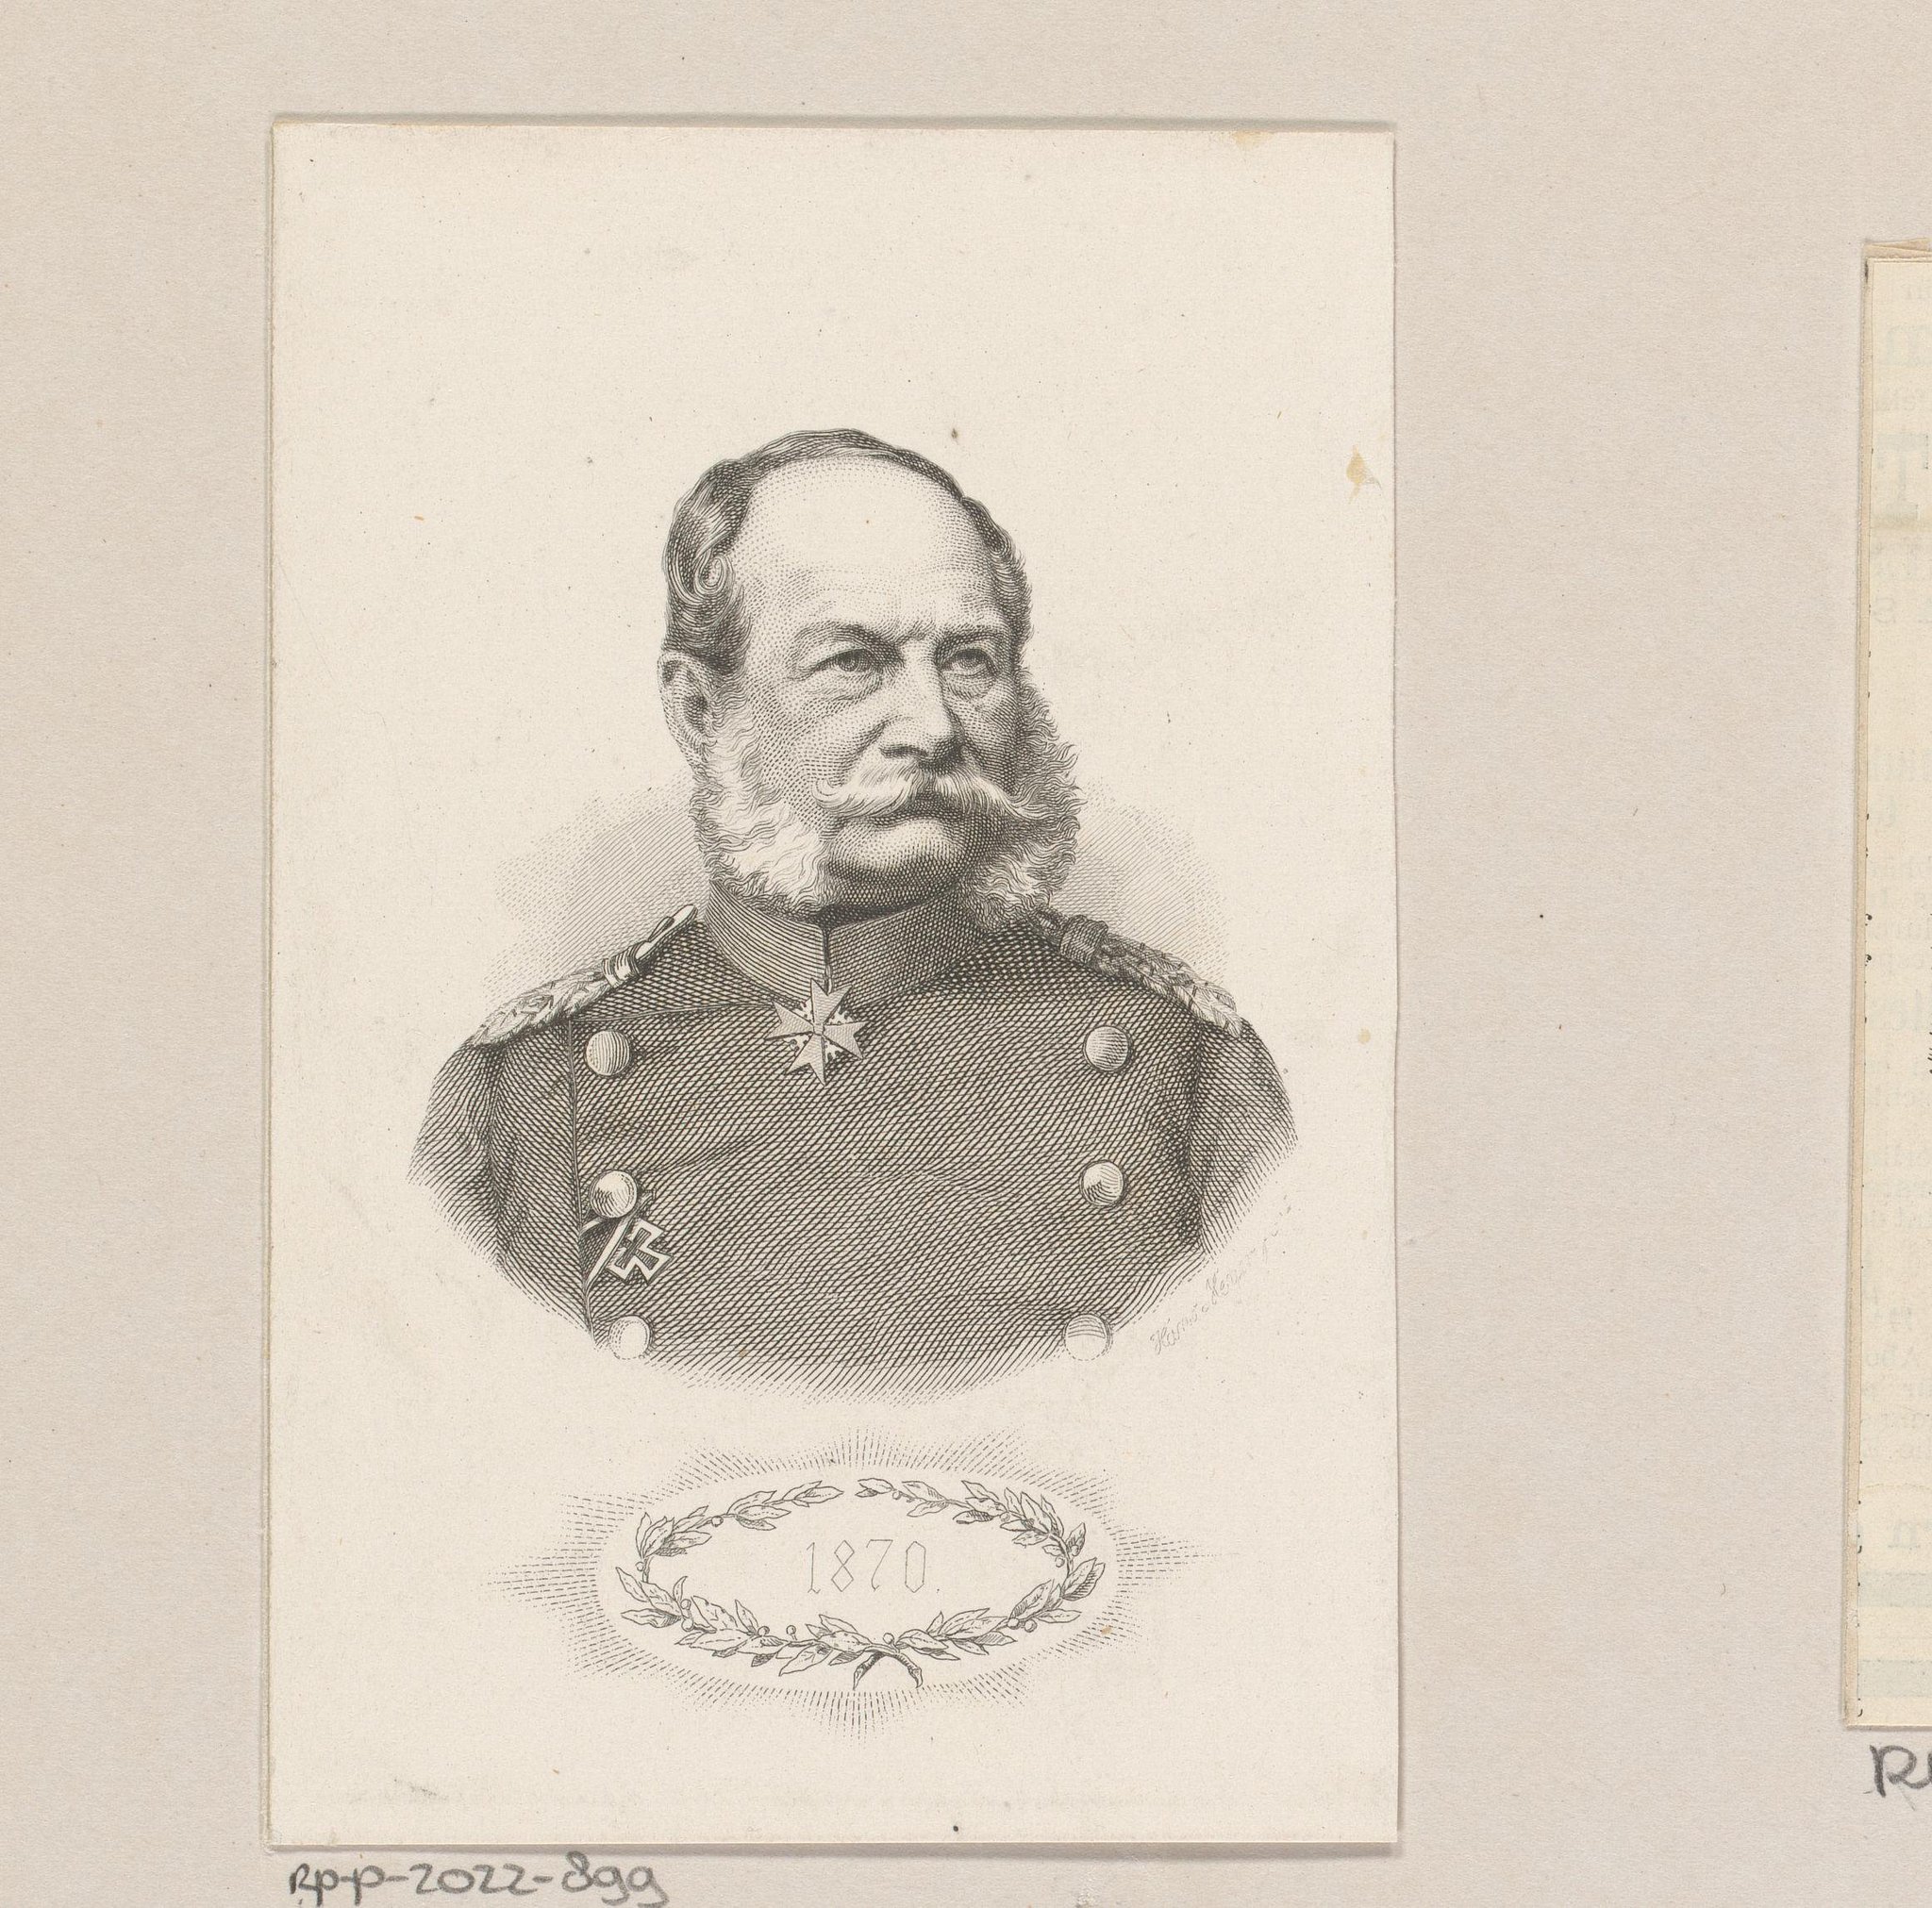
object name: print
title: Portret van Wilhelm I van Duitsland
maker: hans meyer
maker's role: print maker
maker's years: 1846-1919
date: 1871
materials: paper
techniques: engraving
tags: berlin, wilhelm i (keizer van duitsland), historical persons, ranks ~ rulers, sovereigns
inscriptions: collector's mark: Lugt 2228, inscription: ‘A. de G. 1871.’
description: Prent waarschijnlijk uit: Almanach de Gotha: annuaire généalogique, diplomatique et statistique. Gotha: Justus Perthes, 1871.